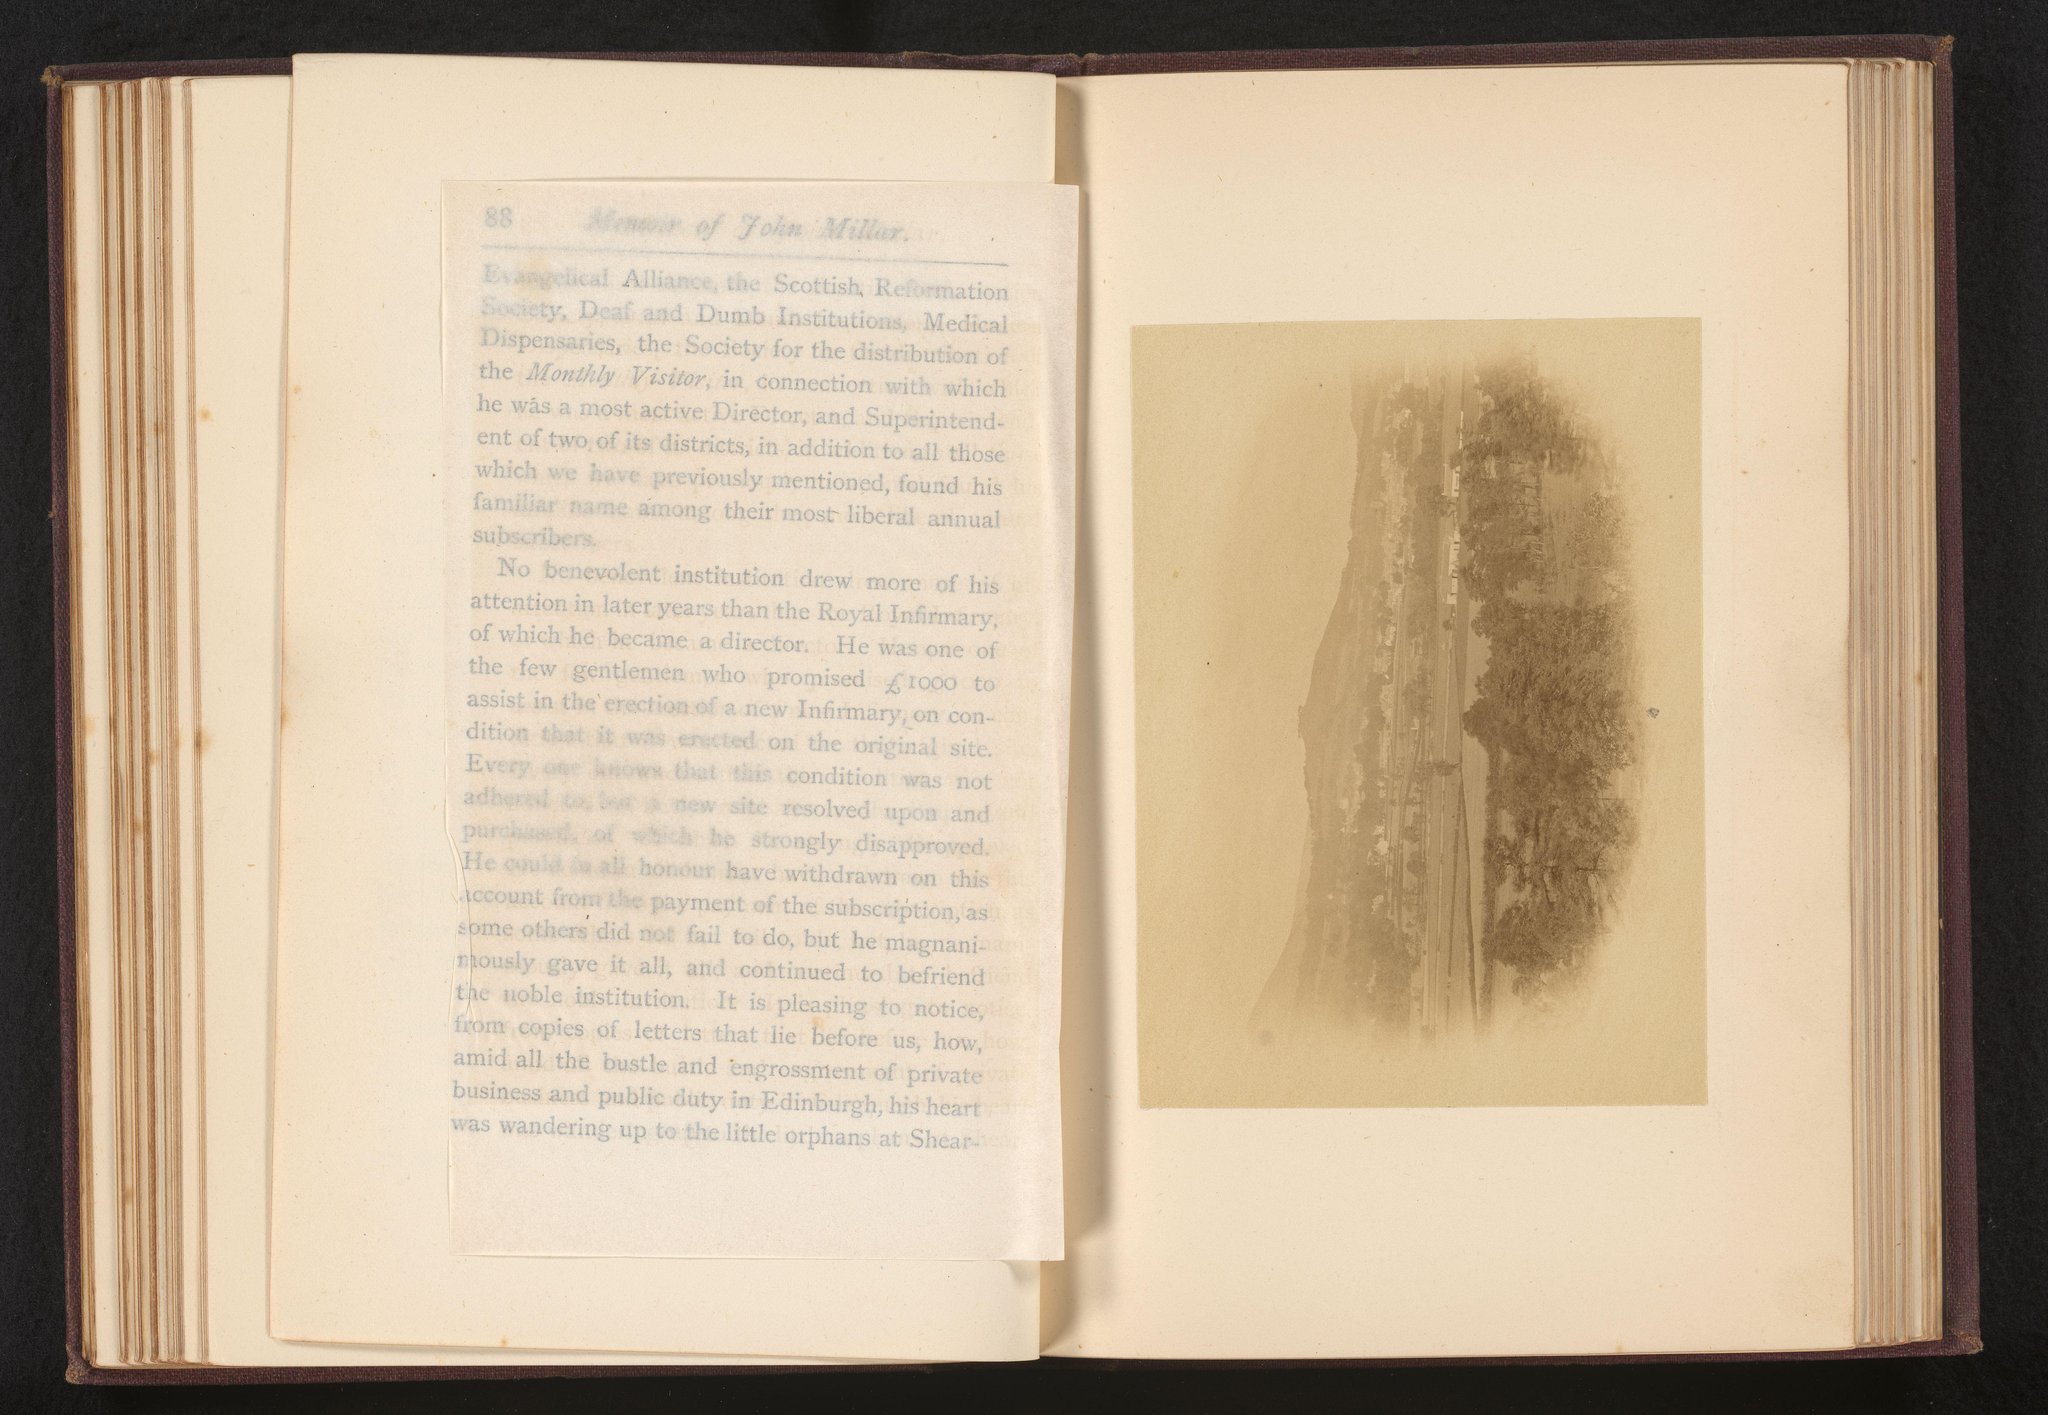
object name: page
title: Landschap in Groot Brittanië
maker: Anonymous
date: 1871-1876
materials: paper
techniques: albumen print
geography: great britain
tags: dale, valley, landscapes, great britain